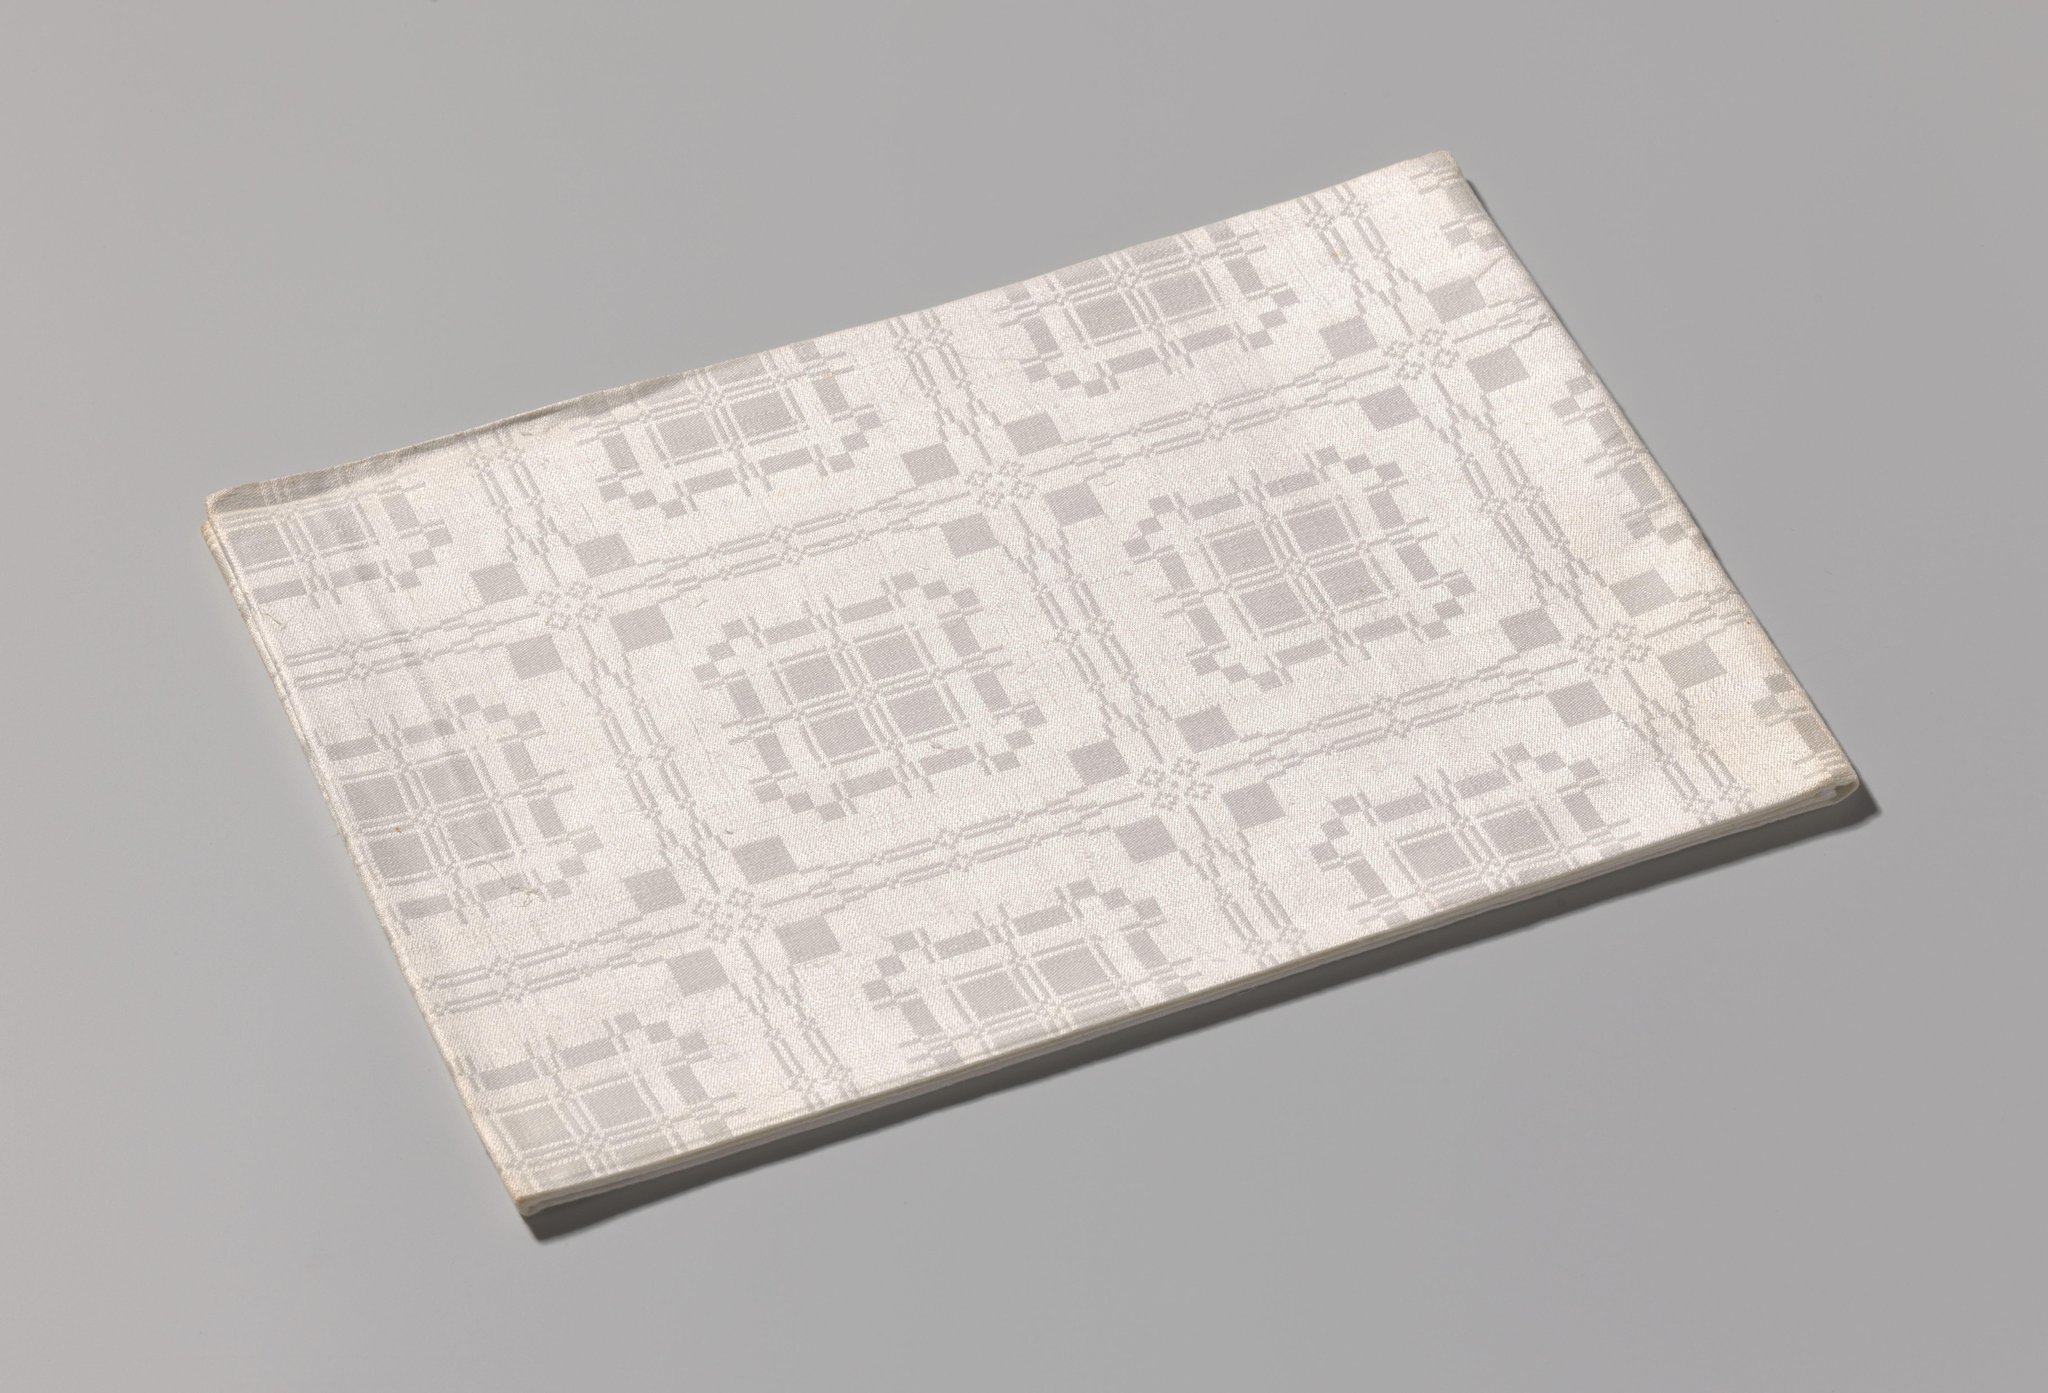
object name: napkin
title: Servet van linnen met pellenpatroon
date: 1400-1950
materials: linen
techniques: peeled fabric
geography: northern netherlands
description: Wit linnendamasten servet met pellenpatroon, merk kroon IS en 36.